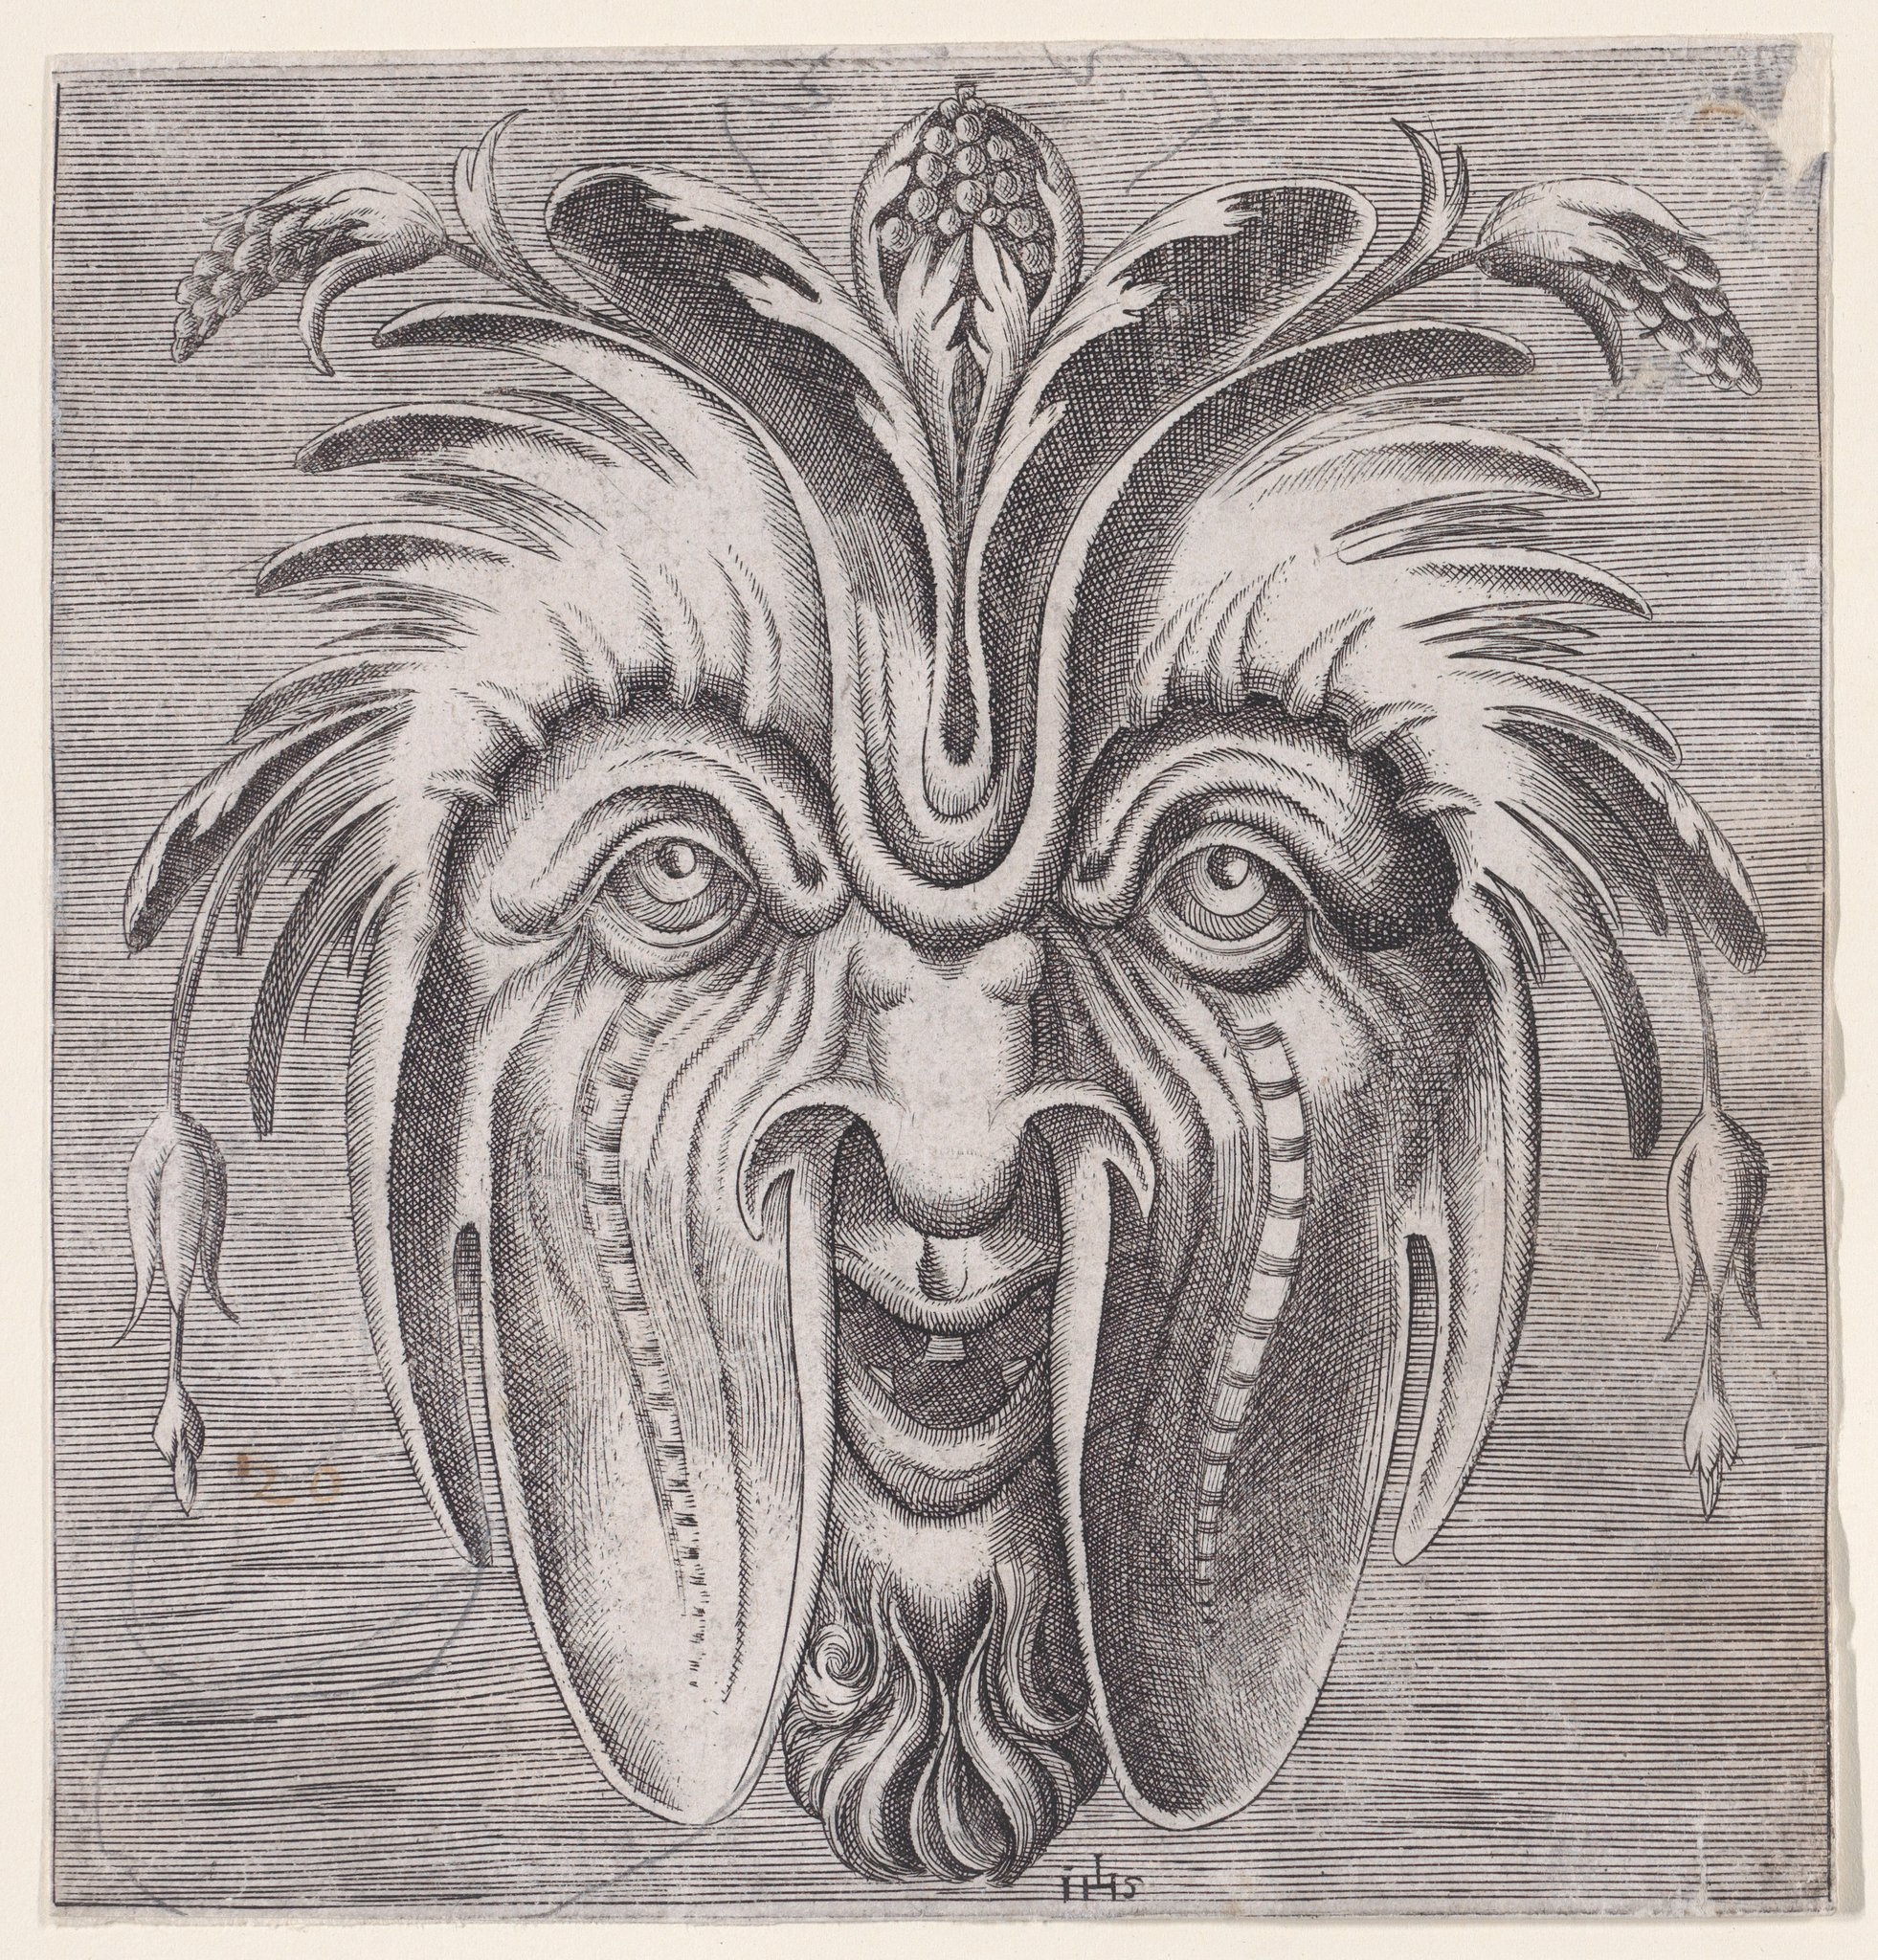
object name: print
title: Mask from Libro di Variate mascare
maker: rené boyvin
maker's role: artist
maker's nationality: french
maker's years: 1525-1598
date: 1560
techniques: engraving